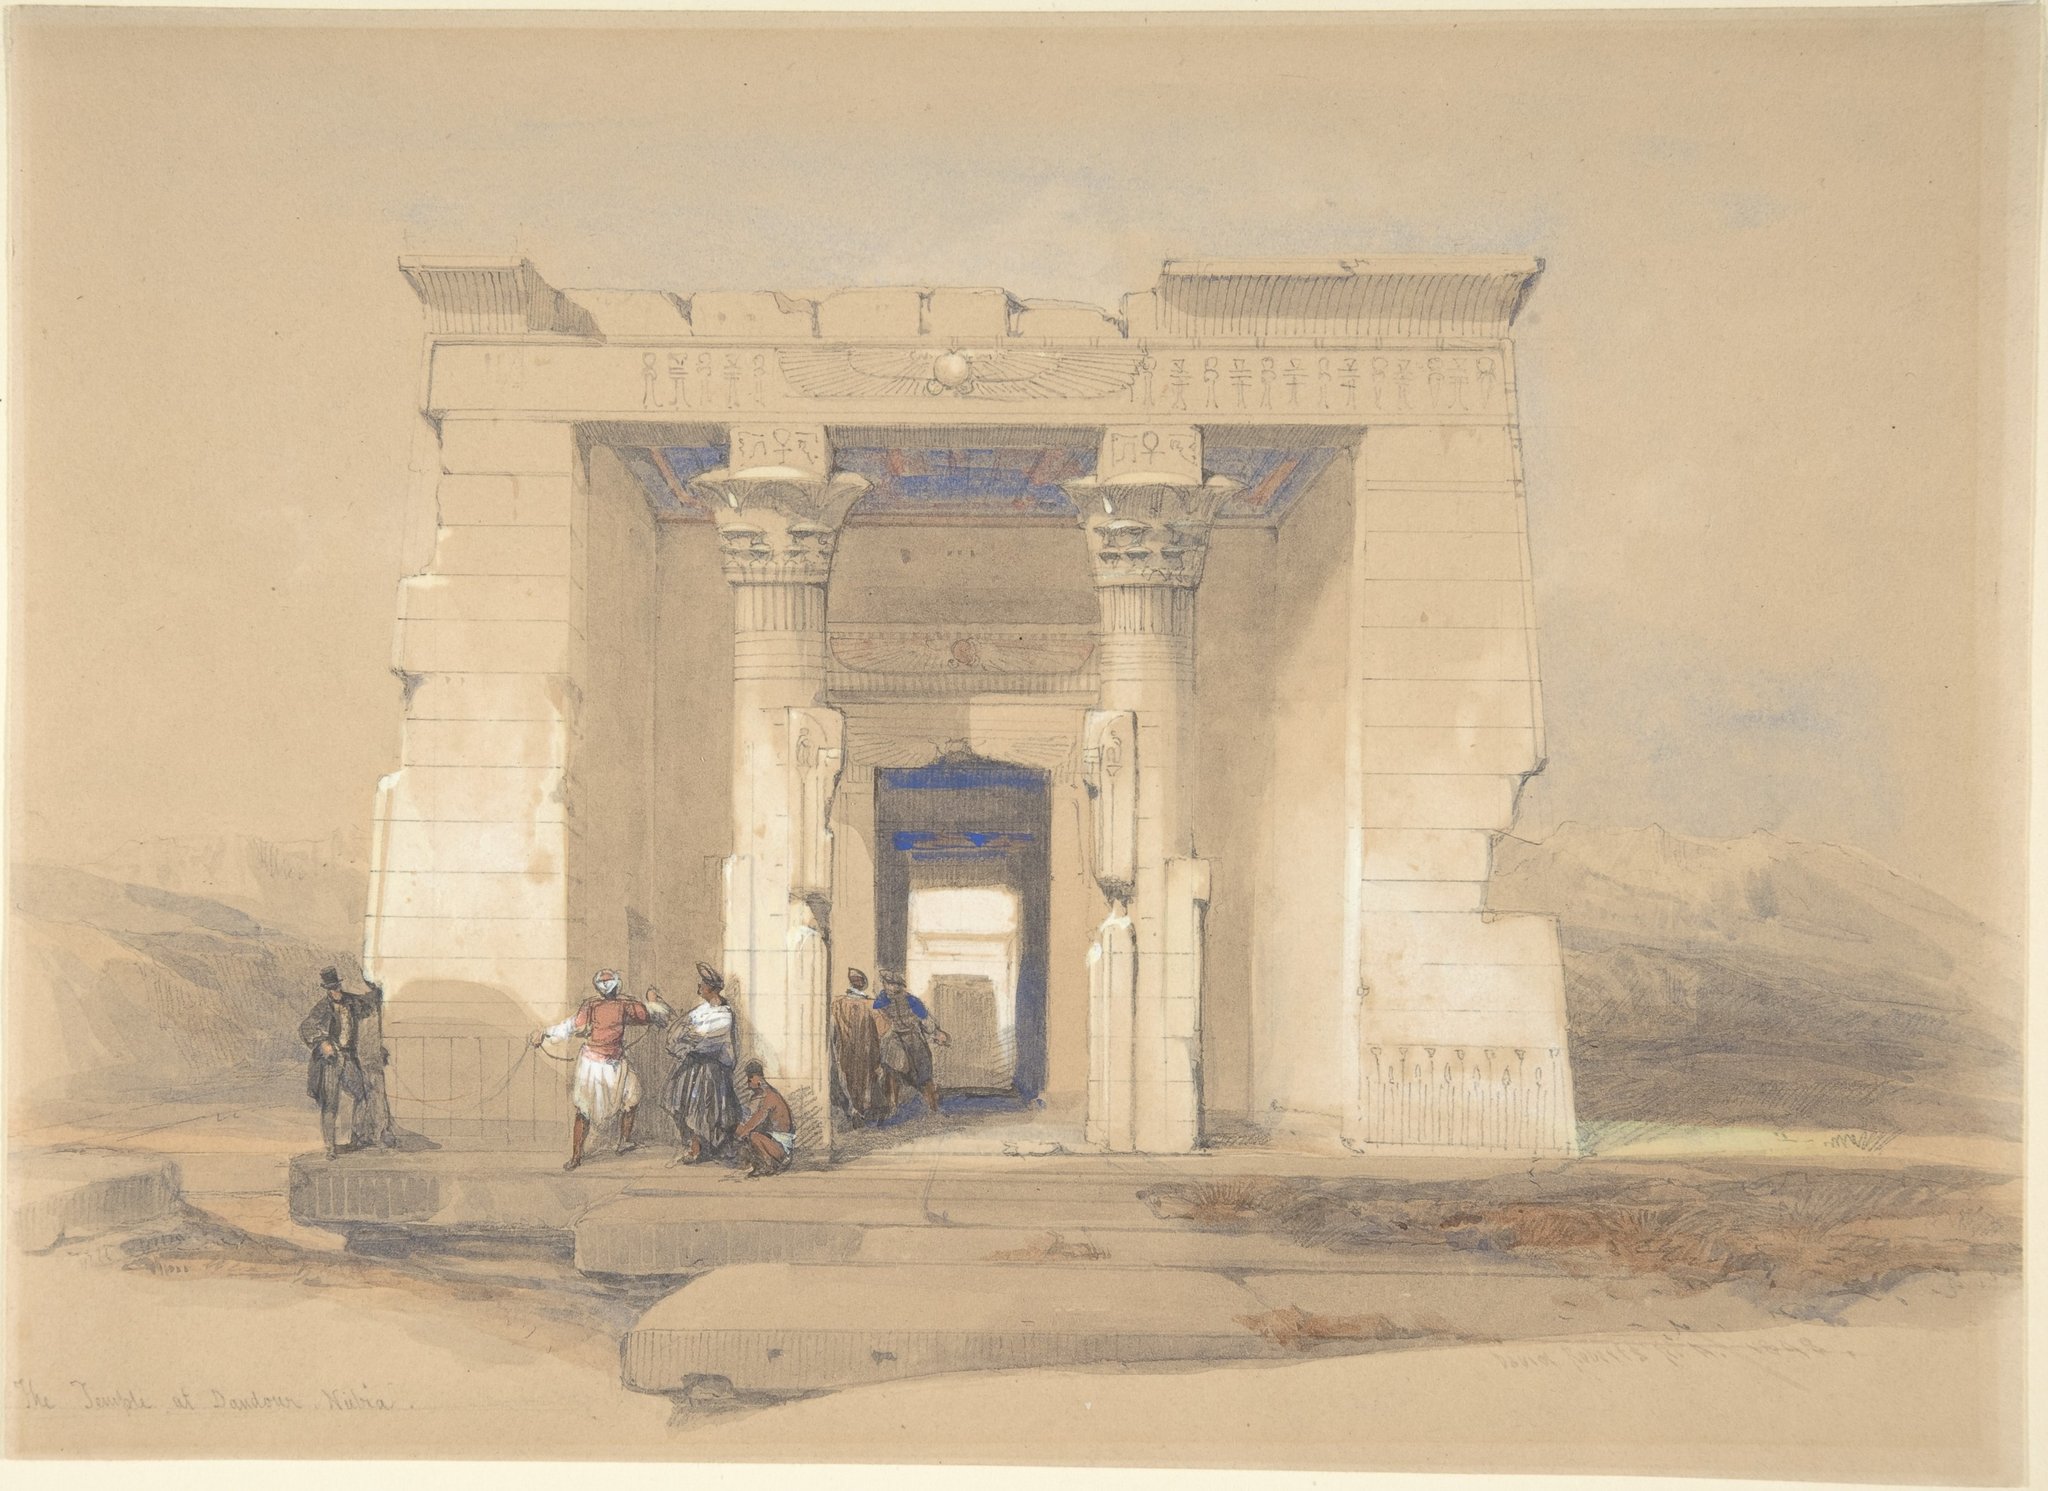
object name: drawing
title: The Temple at Dendur, Nubia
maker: david roberts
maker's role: artist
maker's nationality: british, scottish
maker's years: 1796-1864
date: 1848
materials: gouache, graphite, watercolor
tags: columns,temples,ruins,men